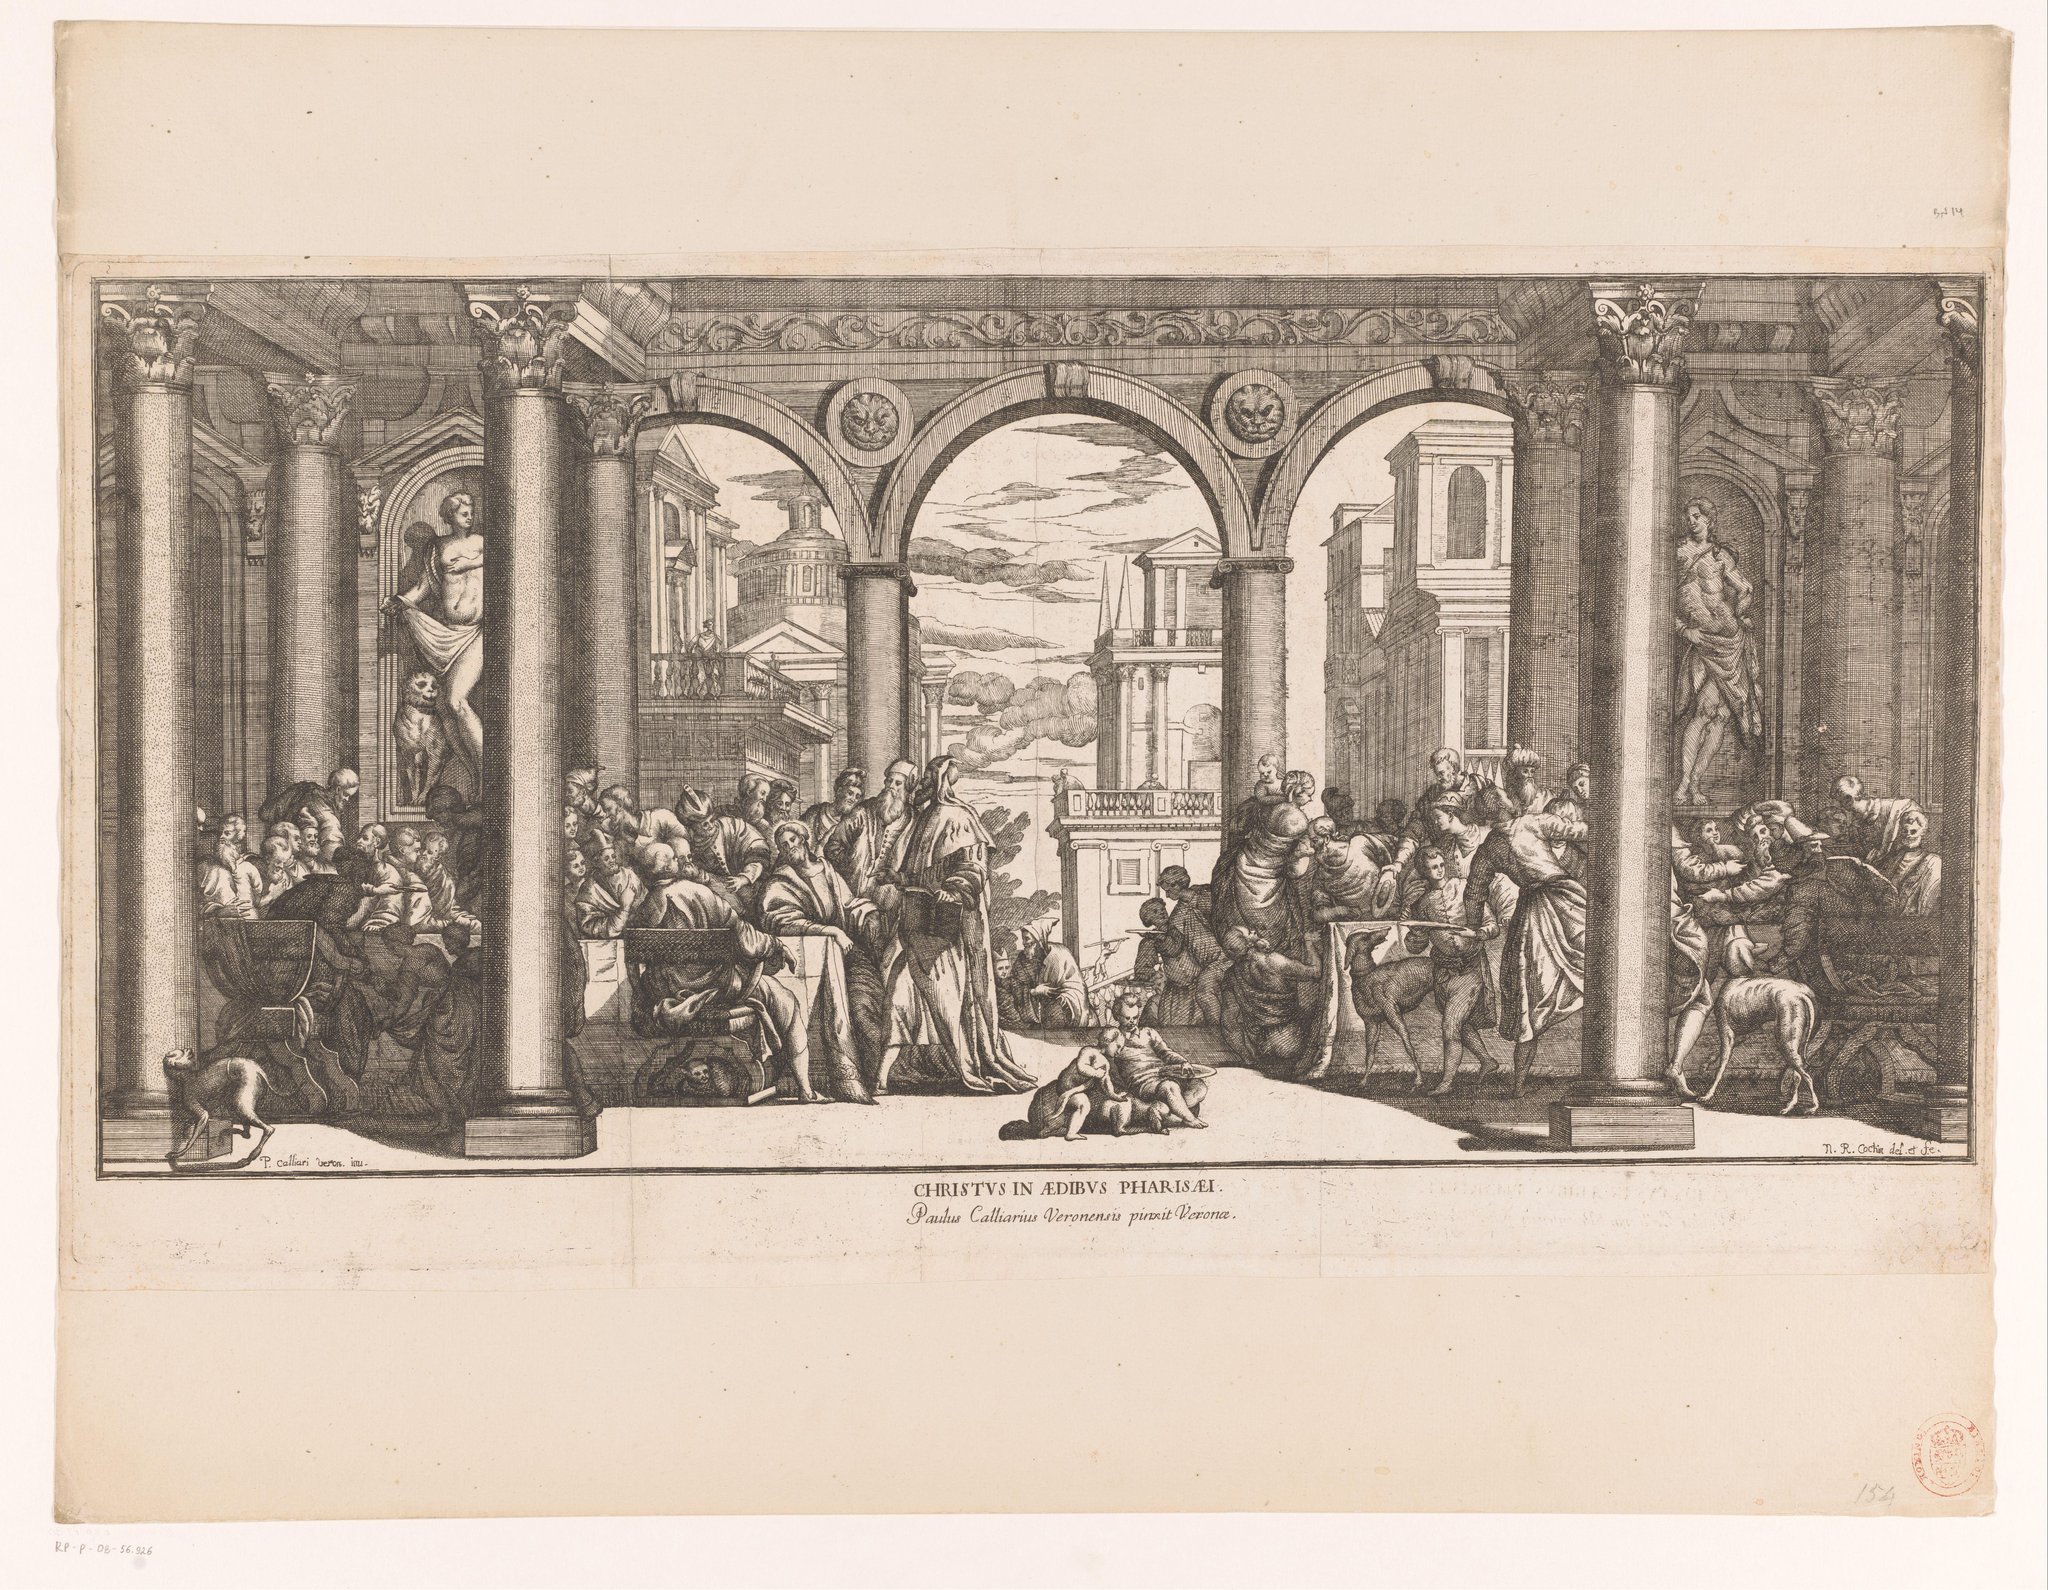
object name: print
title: Christus en de Farizeeërs in de tempel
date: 1620-1686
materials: paper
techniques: engraving, etching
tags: christ (in the temple) in debate with pharisees about the tribute to caesar (matthew 22:15-22; mark 12:13-17; luke 20:20-26)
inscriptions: collector's mark: Lugt 240